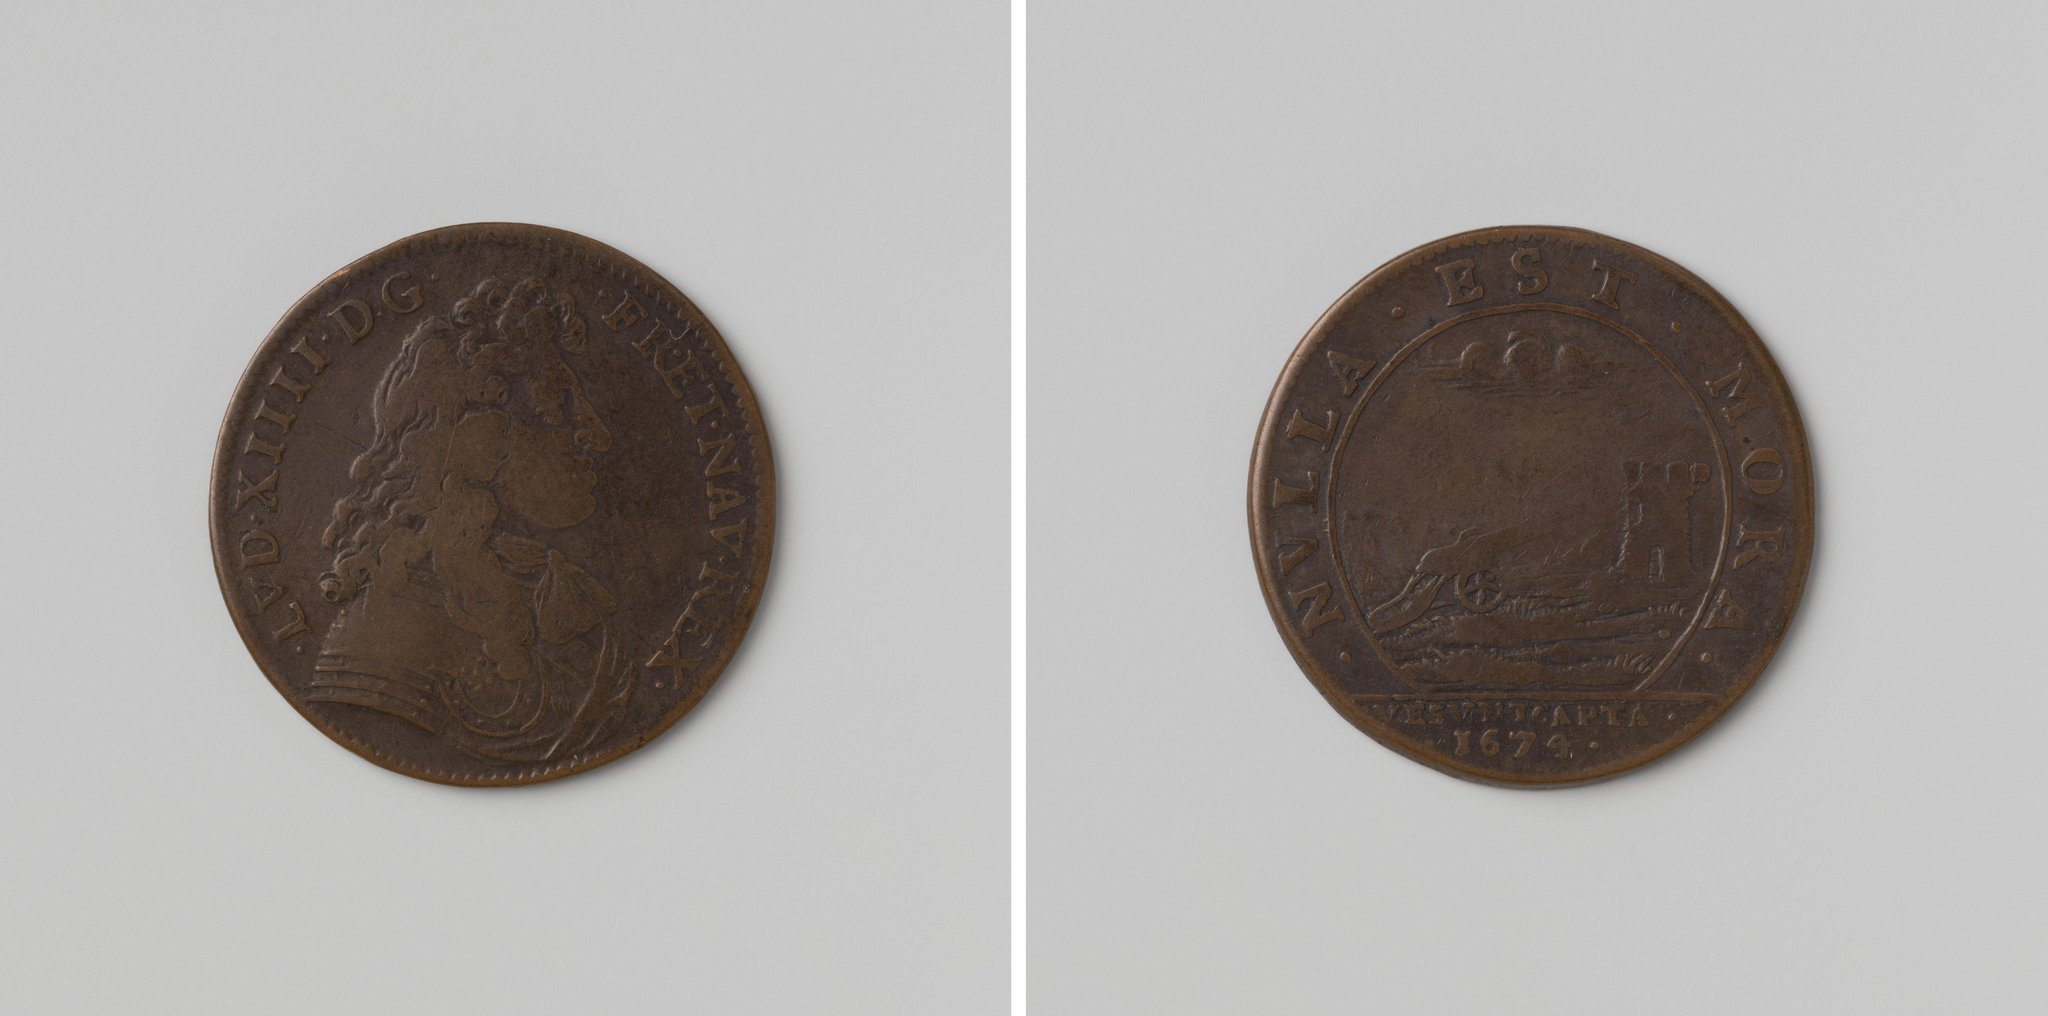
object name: jeton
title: Besancon opnieuw door de Fransen ingenomen, rekenpenning geslagen op last van Lodewijk XIV, koning van Frankrijk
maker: Anonymous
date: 1674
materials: copper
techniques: striking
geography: france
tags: lodewijk xiv (koning van frankrijk)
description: Koperen penning. Voorzijde: borststuk man binnen omschrift. Keerzijde: kanon, staande bij toren binnen omschrift; afsnede: opschrift